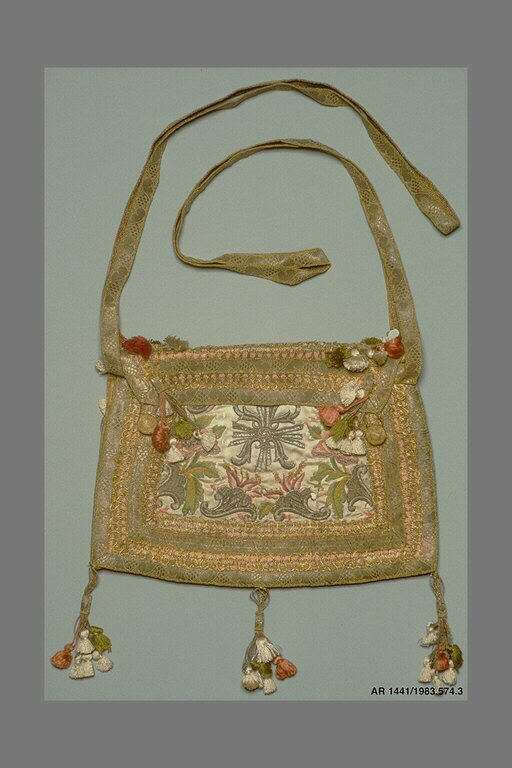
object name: bag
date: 1701-1800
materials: metal thread, silk